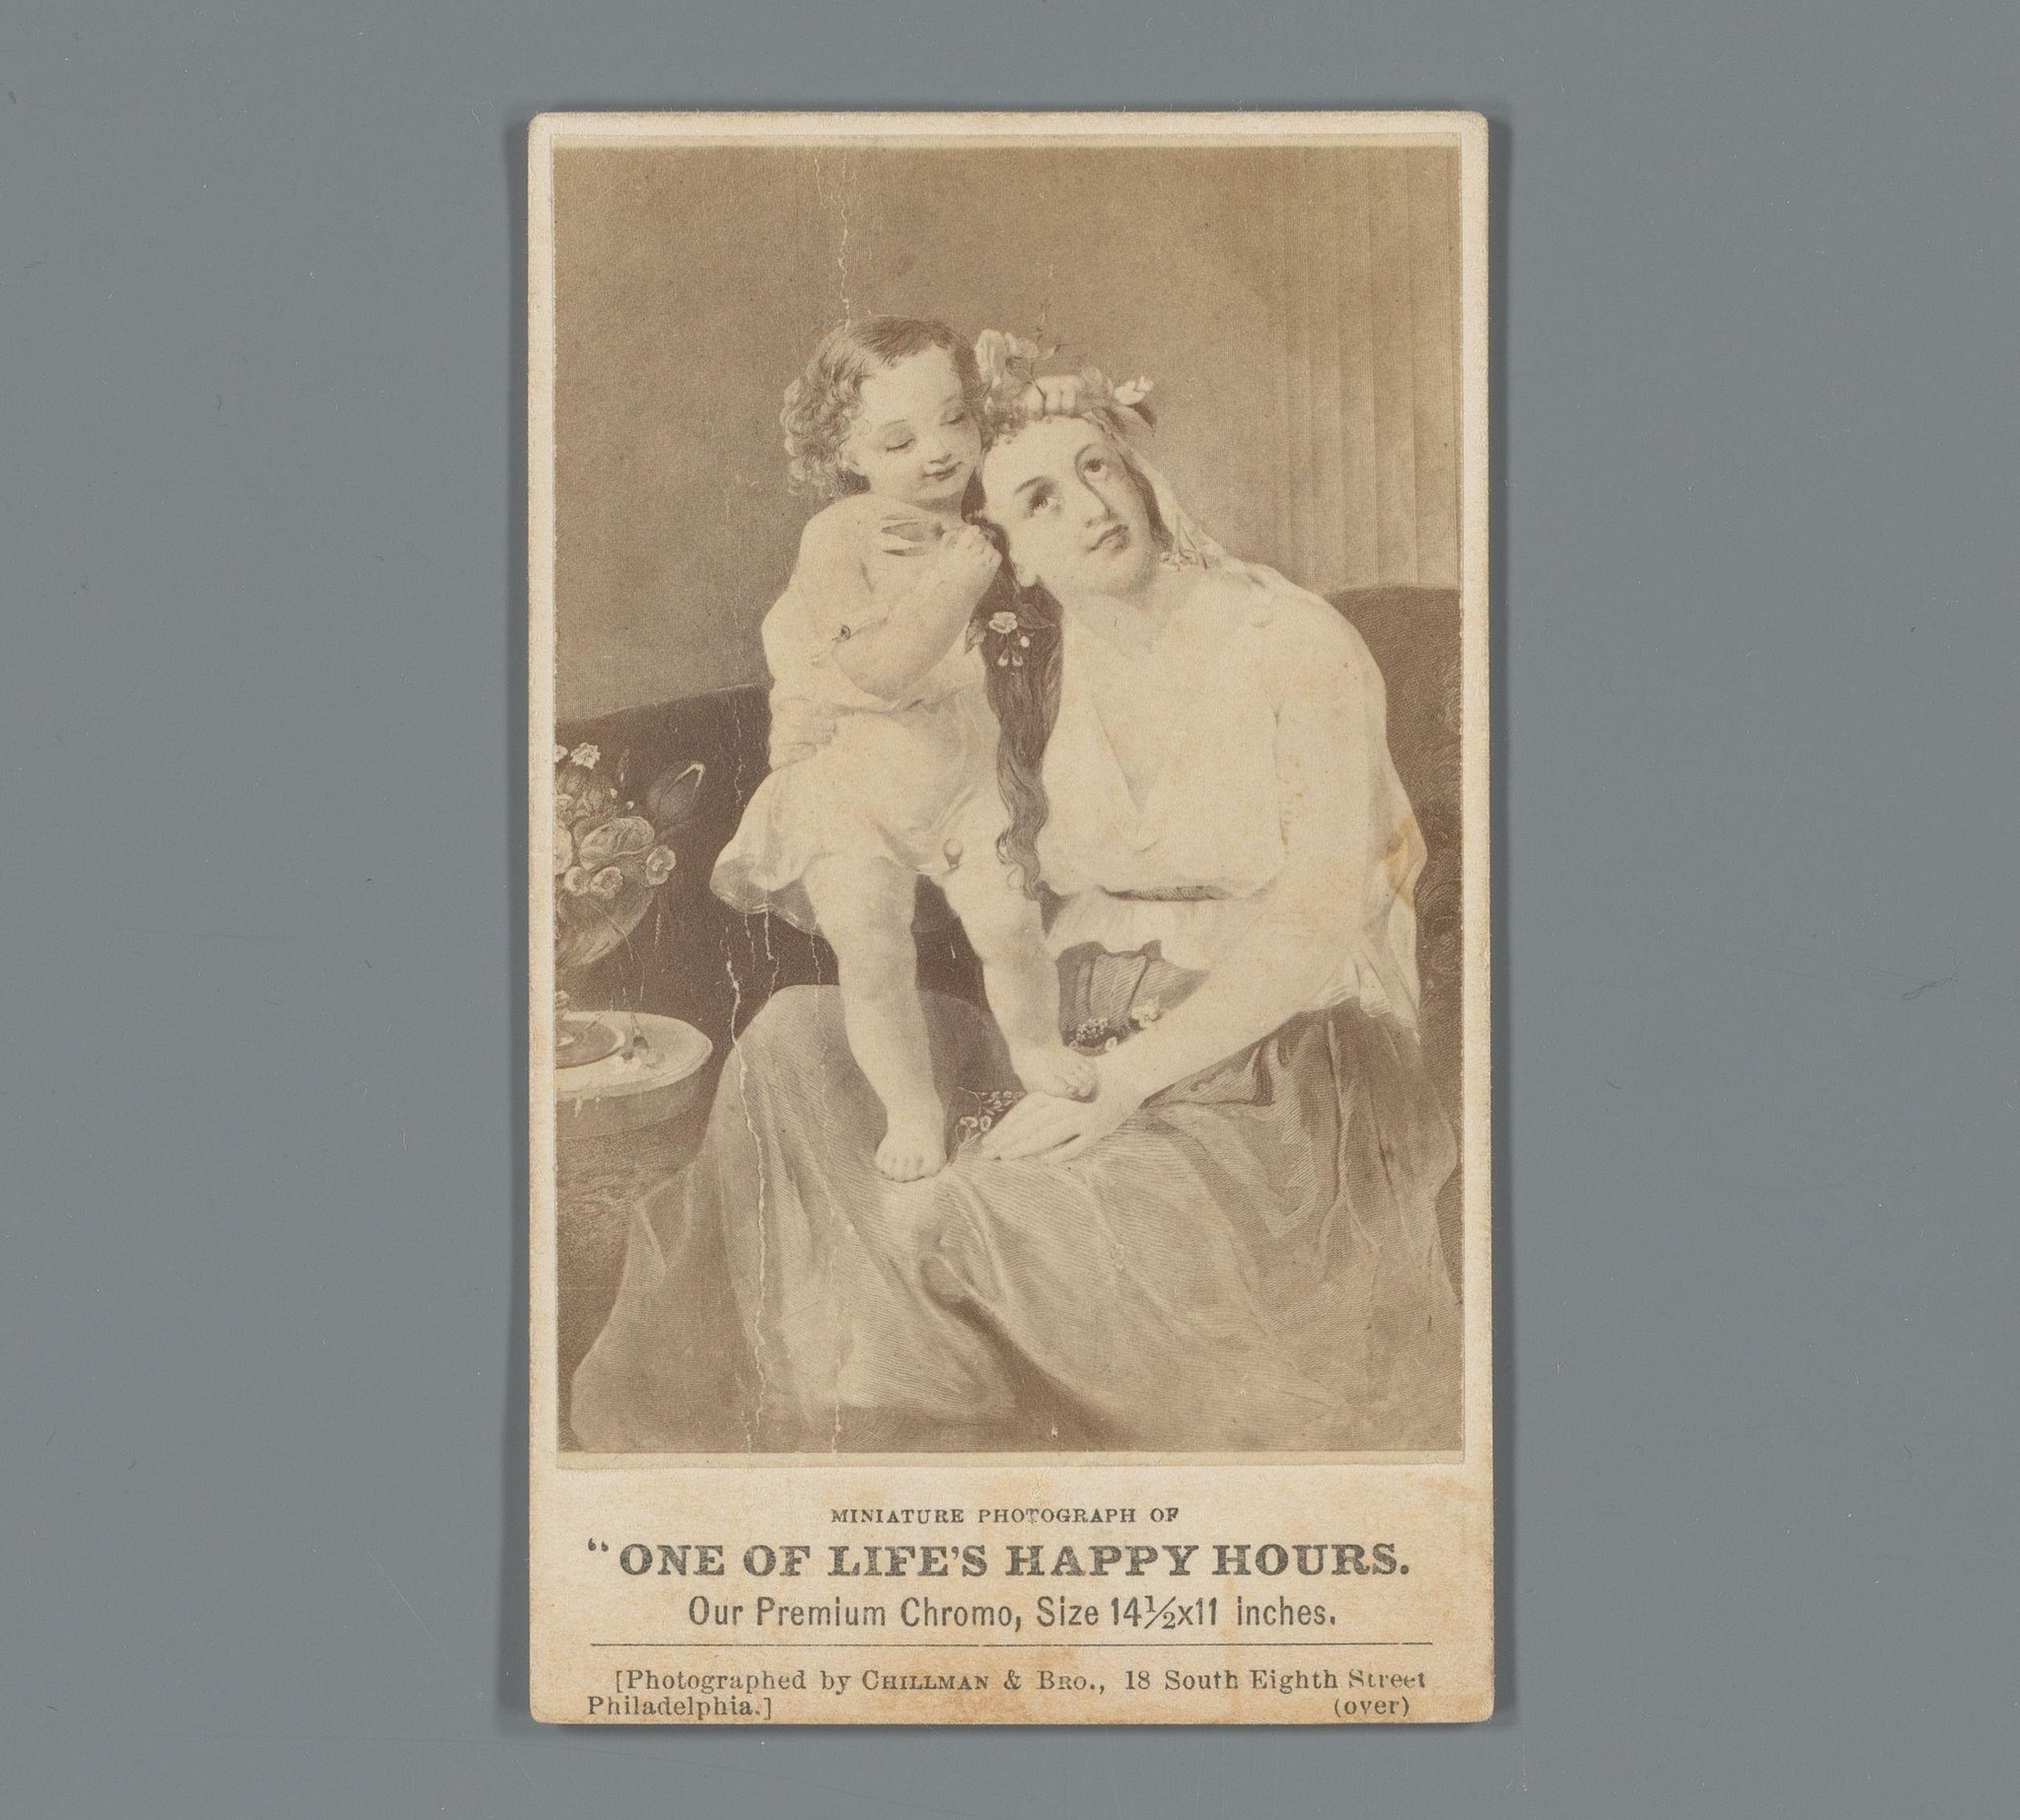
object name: photograph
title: One of life's happy hours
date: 1850-1915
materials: cardboard, photographic support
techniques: albumen print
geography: philadelphia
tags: weekly, monthly, magazine, etc., advertising, mother and child(ren), woman and child(ren) (family group)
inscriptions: inscription: ‘(...)/ The Saturday Evening Post/ (...)/ Saturday Post Publishing Company,/ No. 319 WALNUT ST., Philadelphia, Pa.’, inscription: ‘(Photographed by CHILLMAN & BROS., 18 South Eigth Street/ Philadelphia.)’